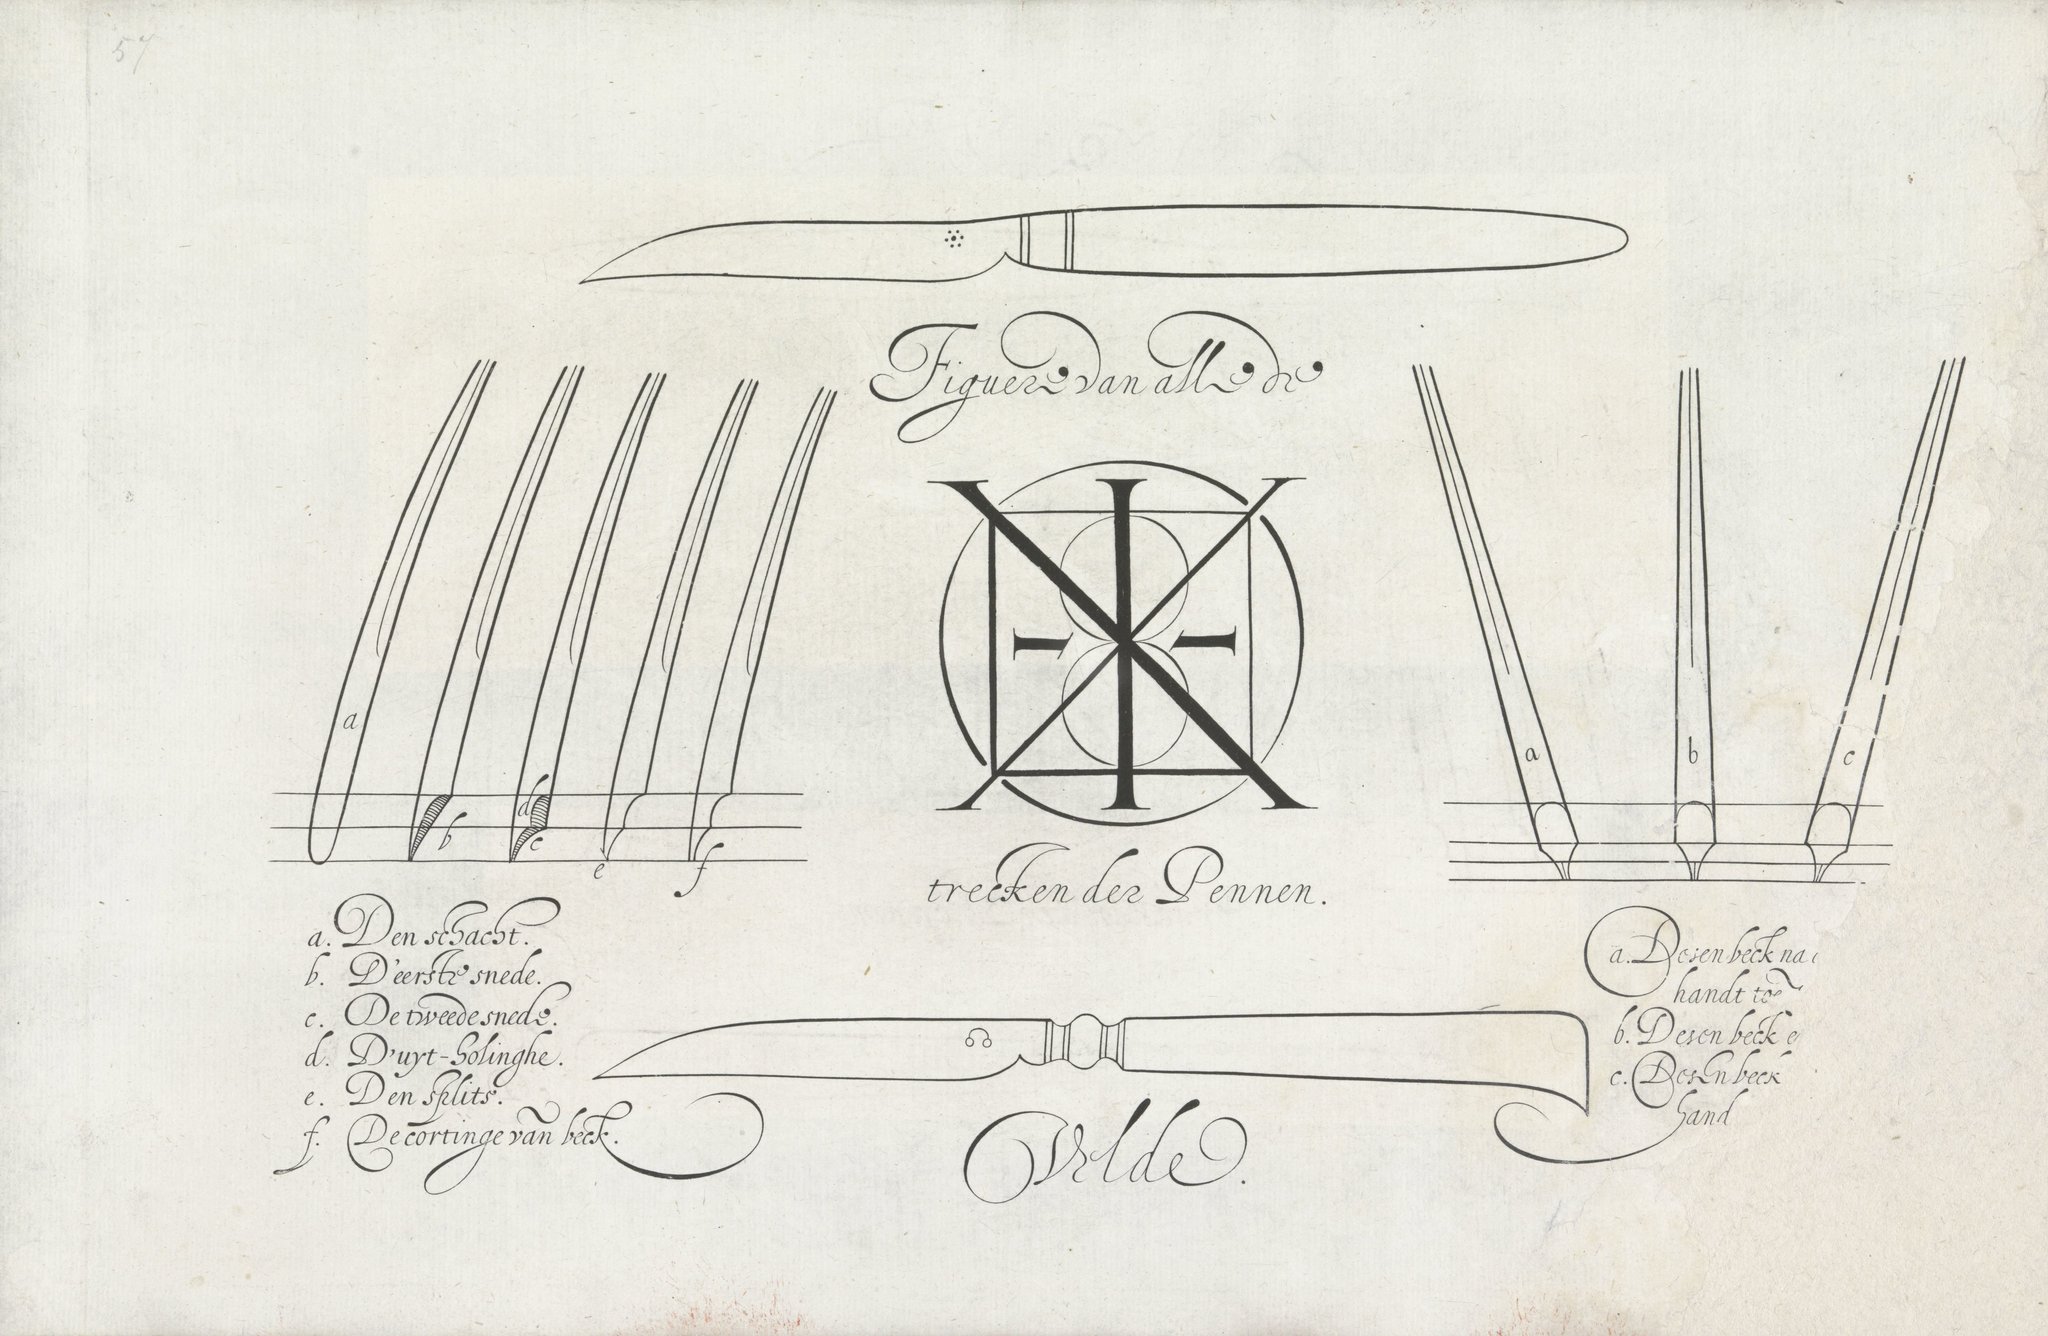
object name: print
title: Figuere van alle de trecken der pennen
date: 1605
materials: paper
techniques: engraving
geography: rotterdam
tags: writing tools, calligraphy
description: Het snijden van een rietpen. In acht stappen wordt verteld hoe de punt gesneden moet worden. Daaronder twee legenda's. Boven en onder een mes. Een geometrisch figuur in het midden. De prent maakt deel uit van een album.